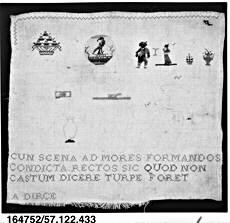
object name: sampler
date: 1801-1900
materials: cotton, linen, silk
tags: human figures